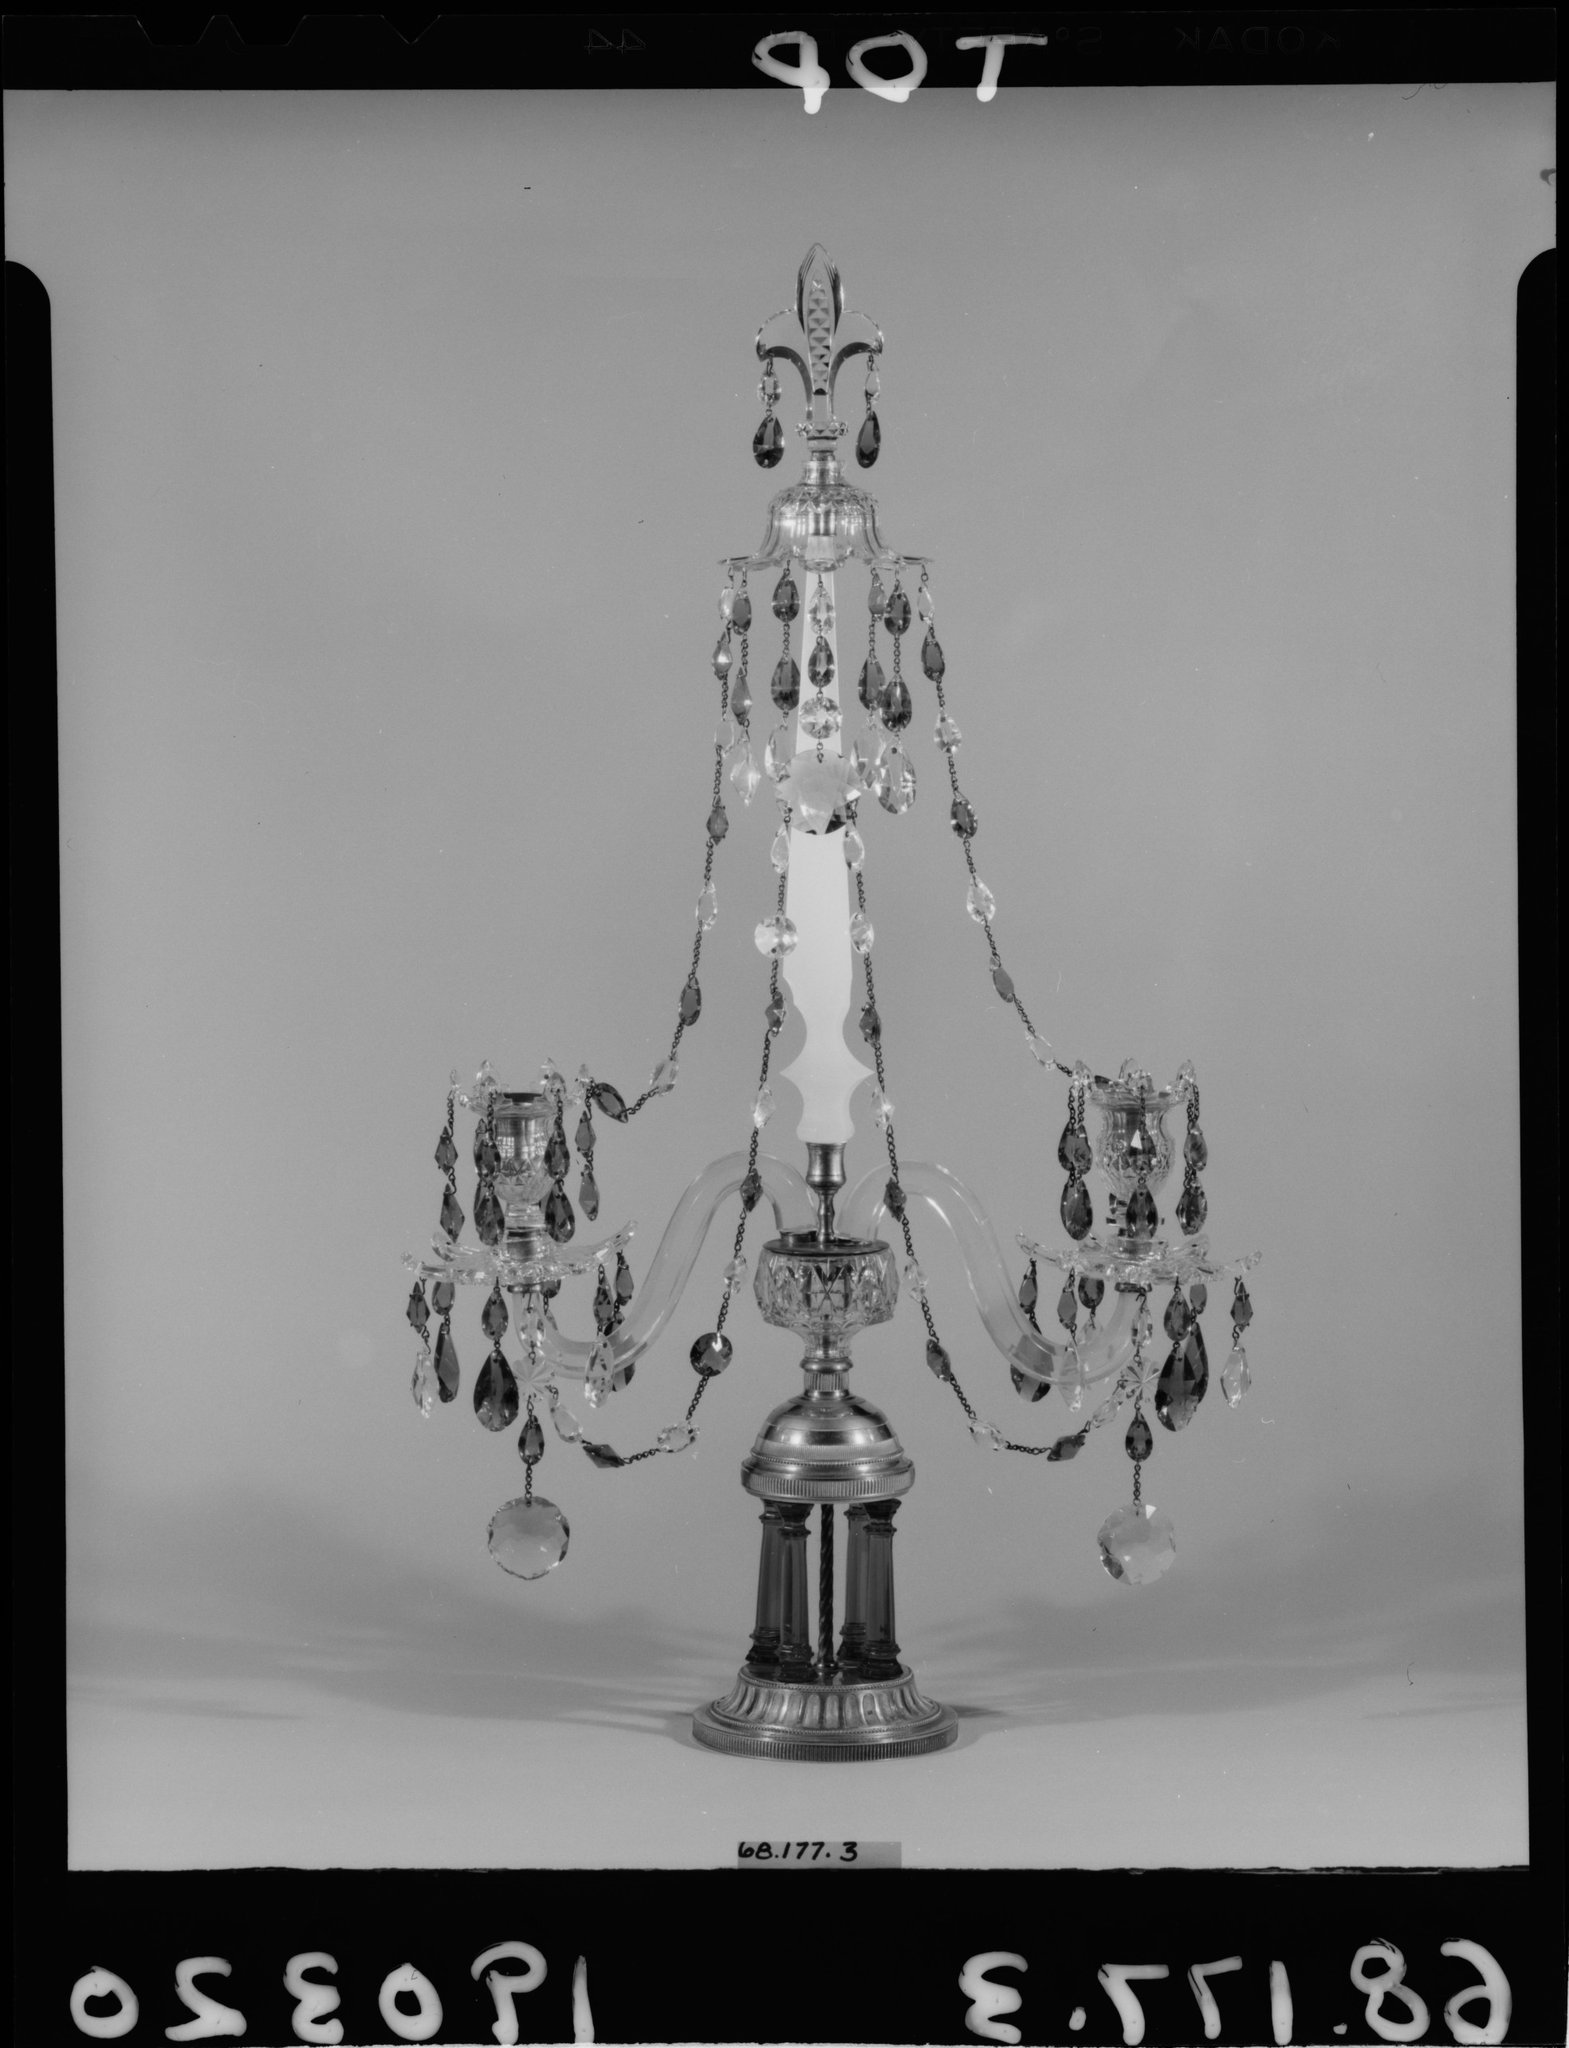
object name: candelabrum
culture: british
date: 1795-1810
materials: gemstone, gilt bronze, glass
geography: england